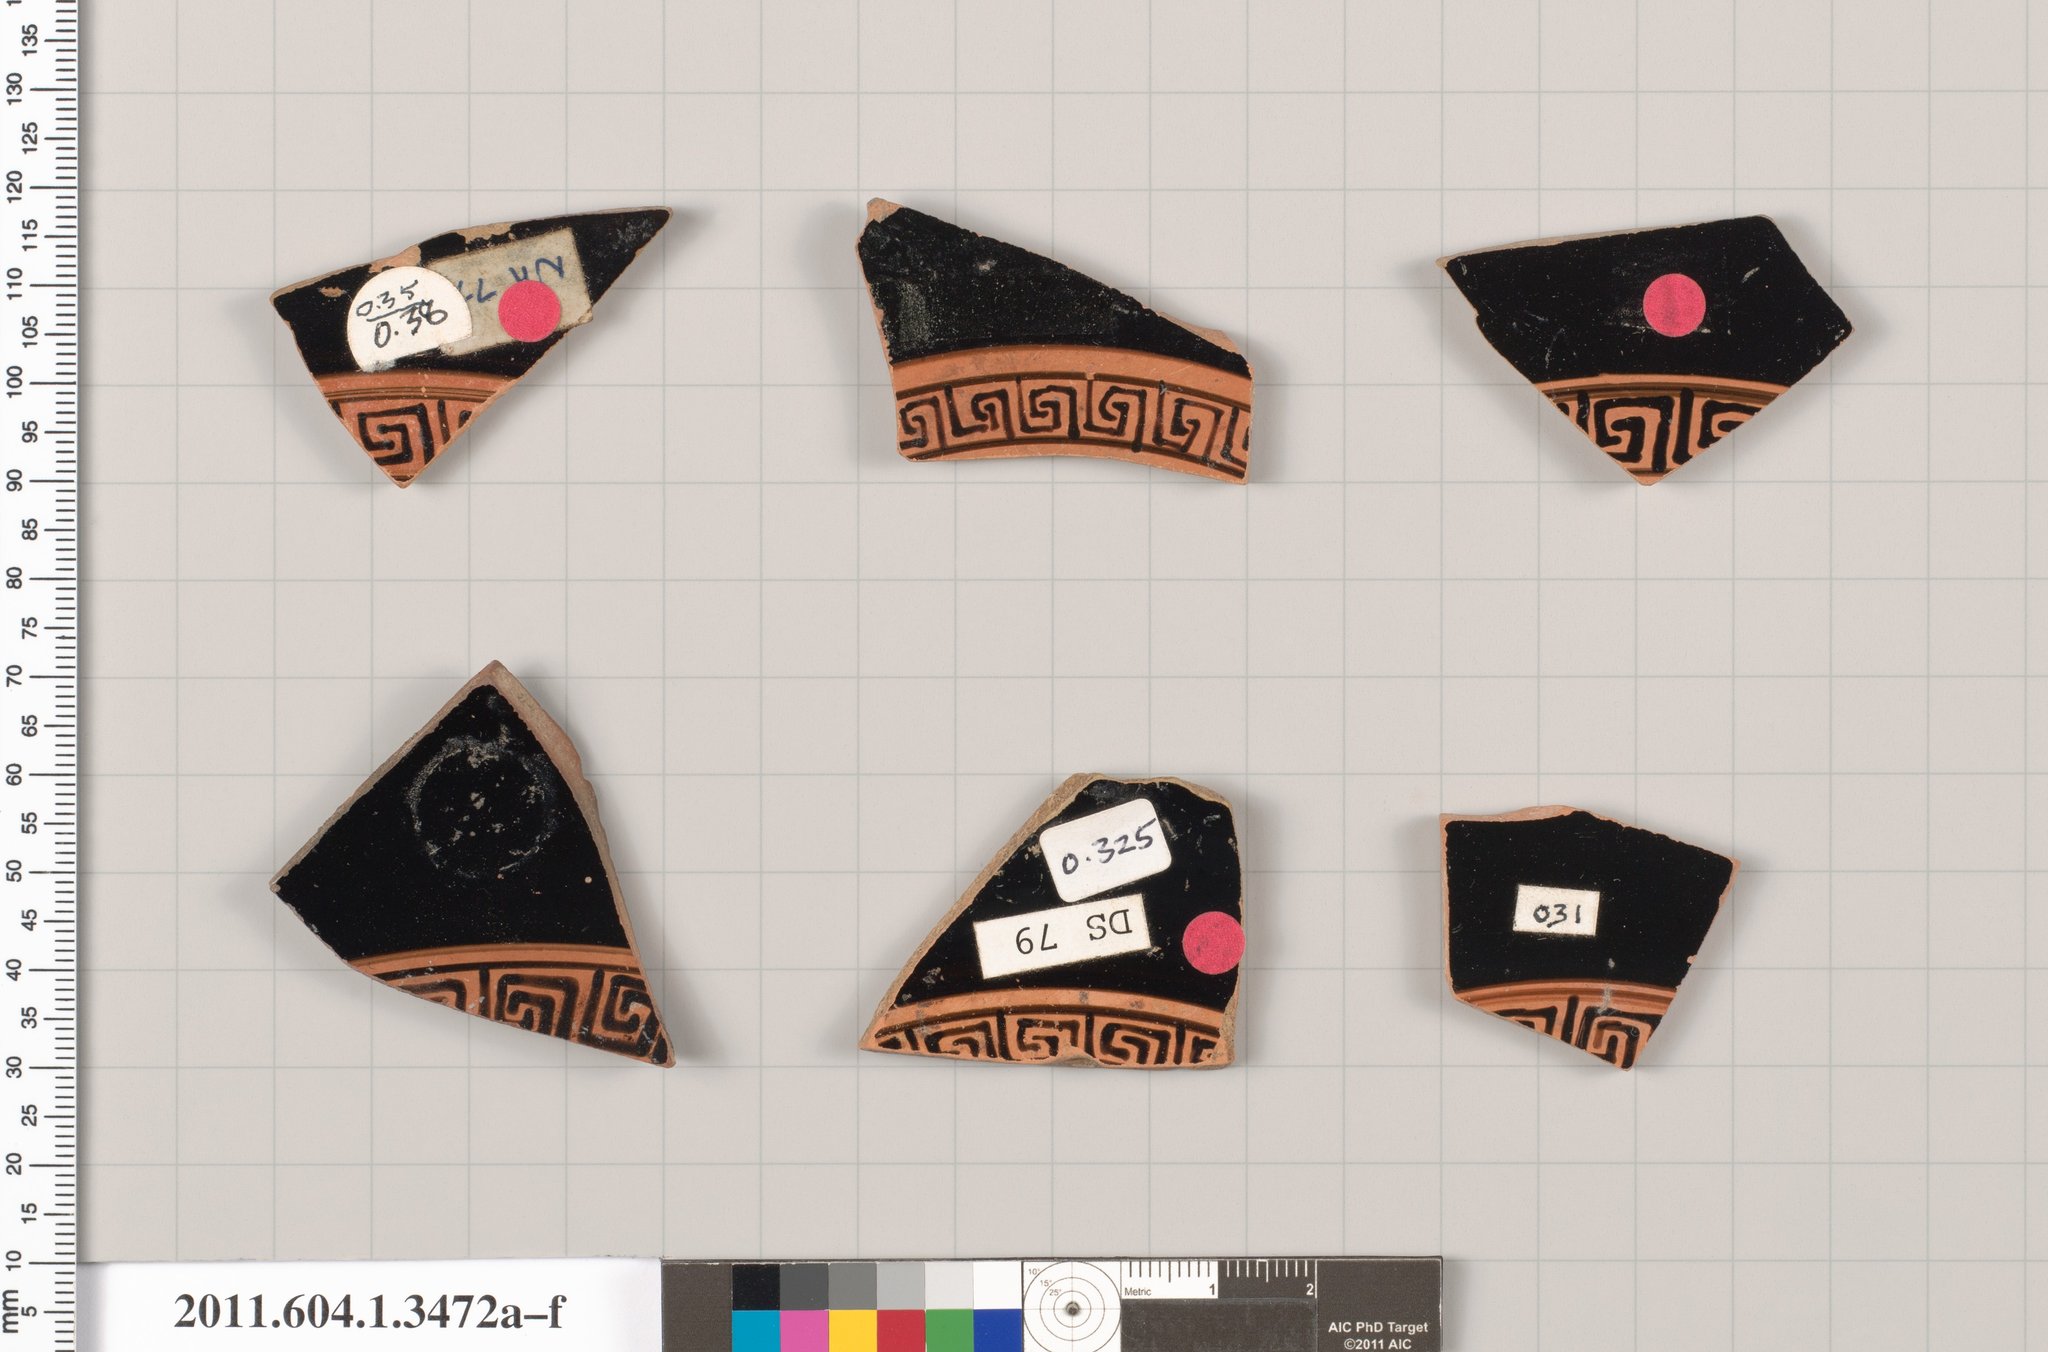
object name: kylix fragment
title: Terracotta fragments of kylikes (drinking cups)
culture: greek, attic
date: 500-475 BCE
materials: terracotta